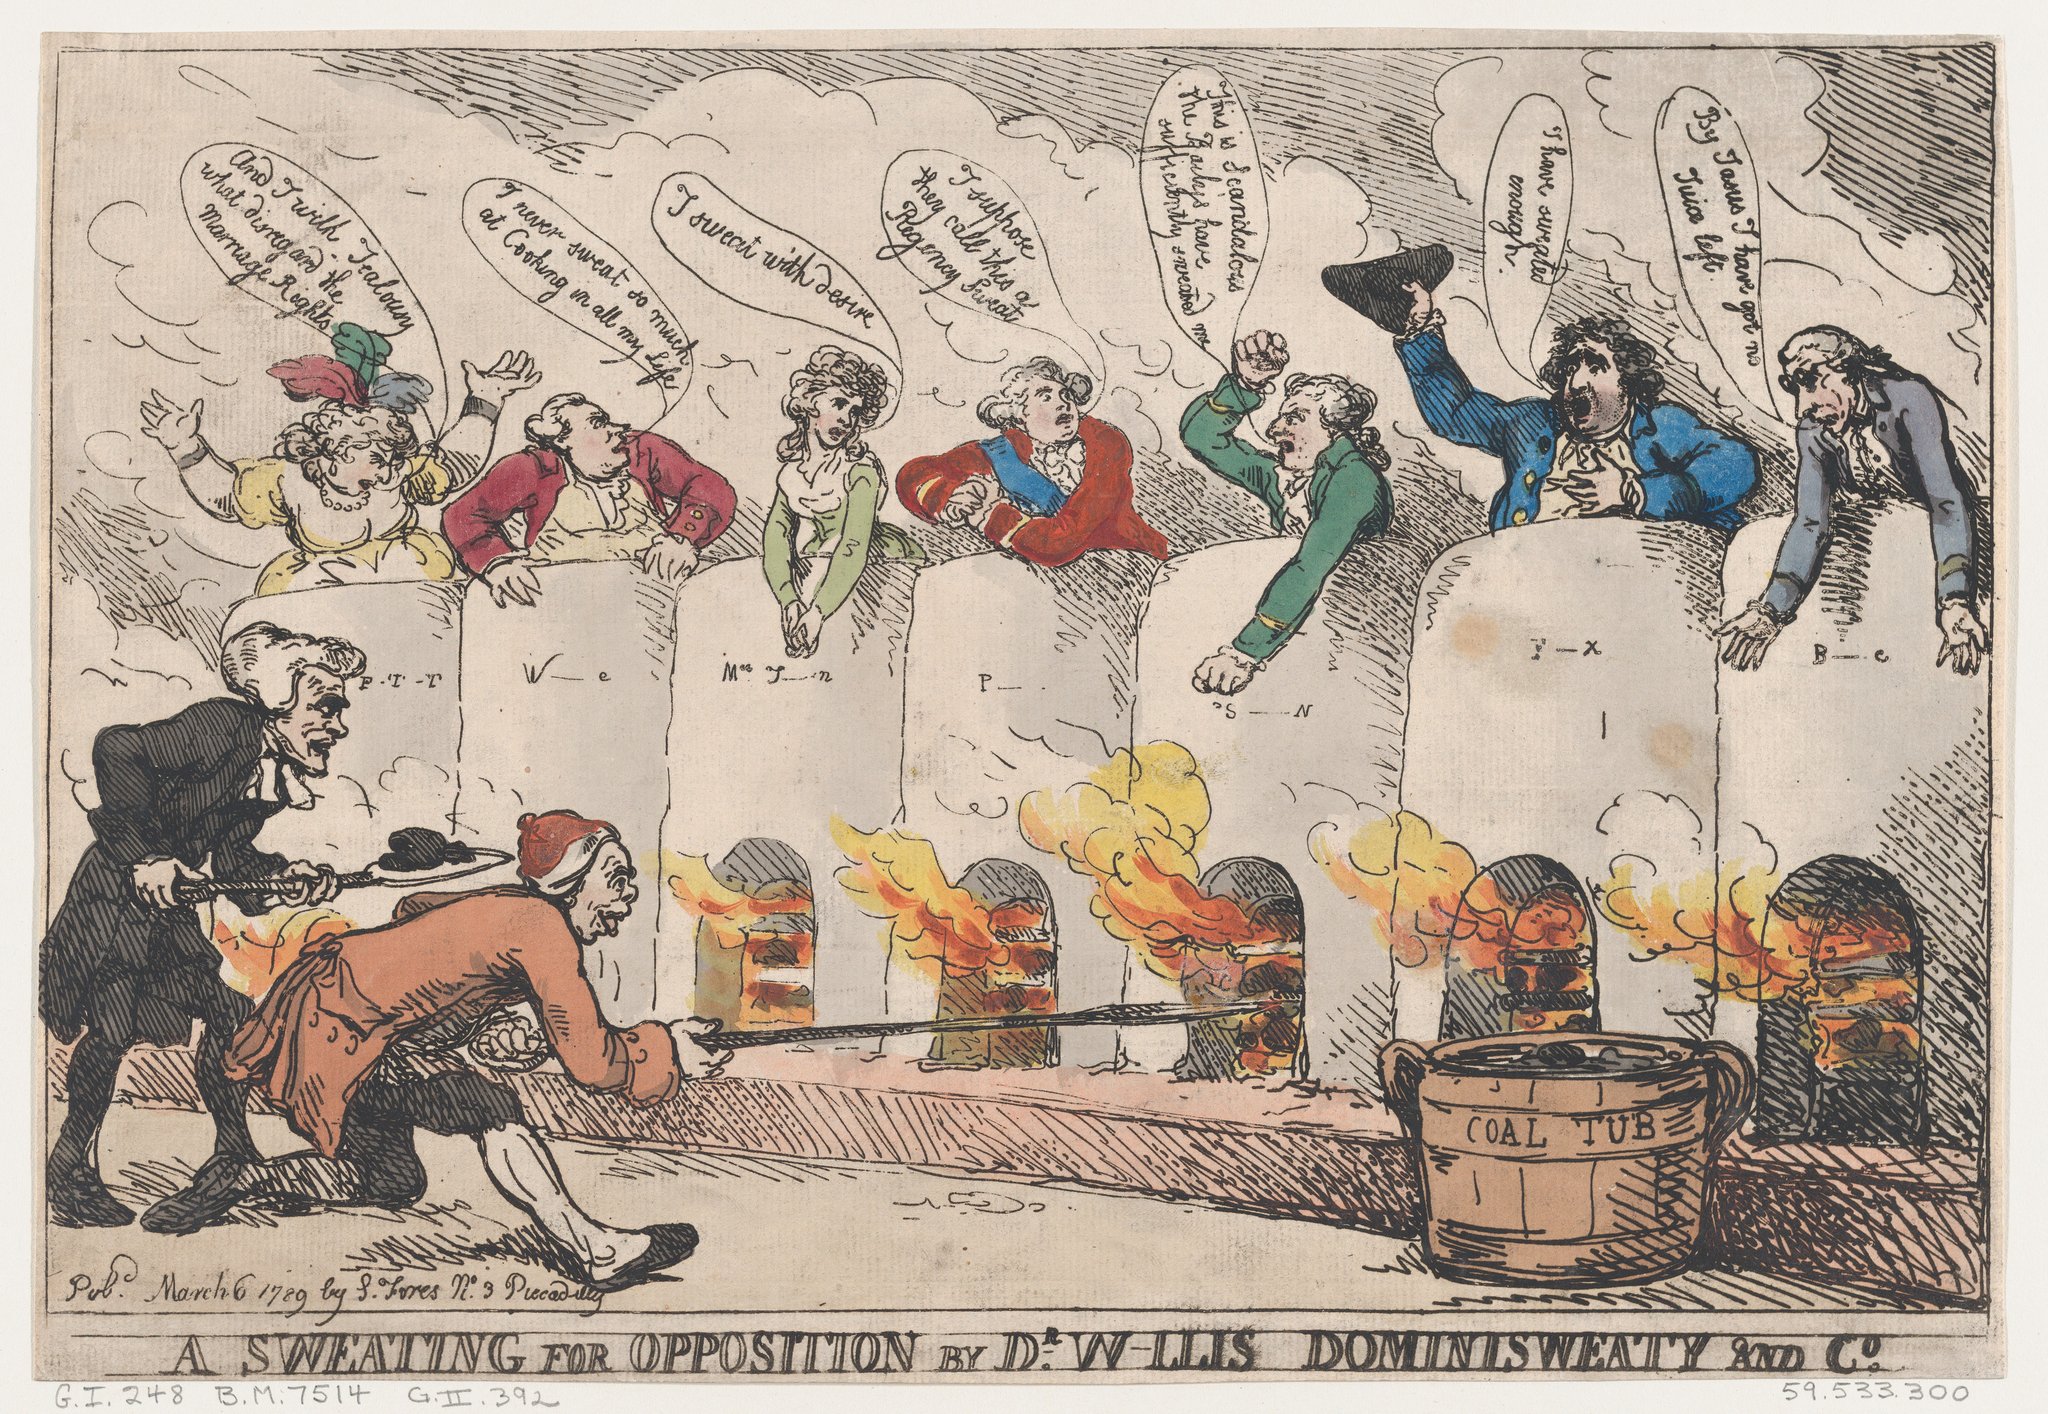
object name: print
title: A Sweating for Opposition by Dr. W-llis Dominisweaty and Co.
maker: thomas rowlandson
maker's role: artist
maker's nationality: british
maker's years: 1757-1827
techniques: aquatint, etching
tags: satire,men,women